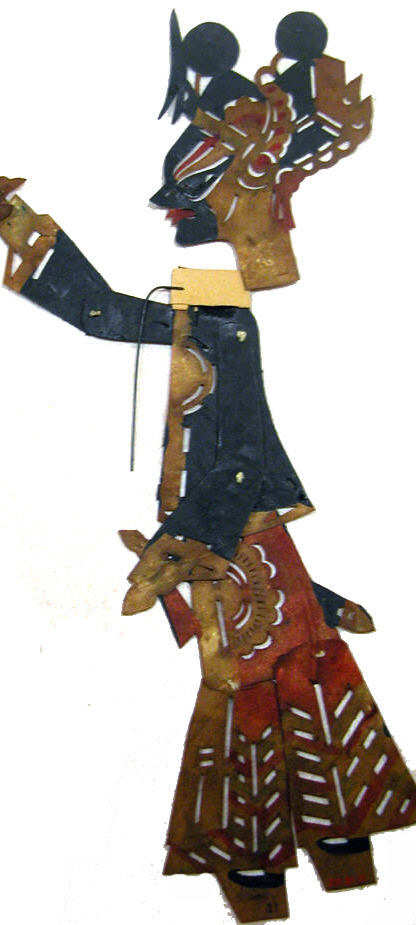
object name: shadow player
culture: chinese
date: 1801-1900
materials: cord, skin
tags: human figures